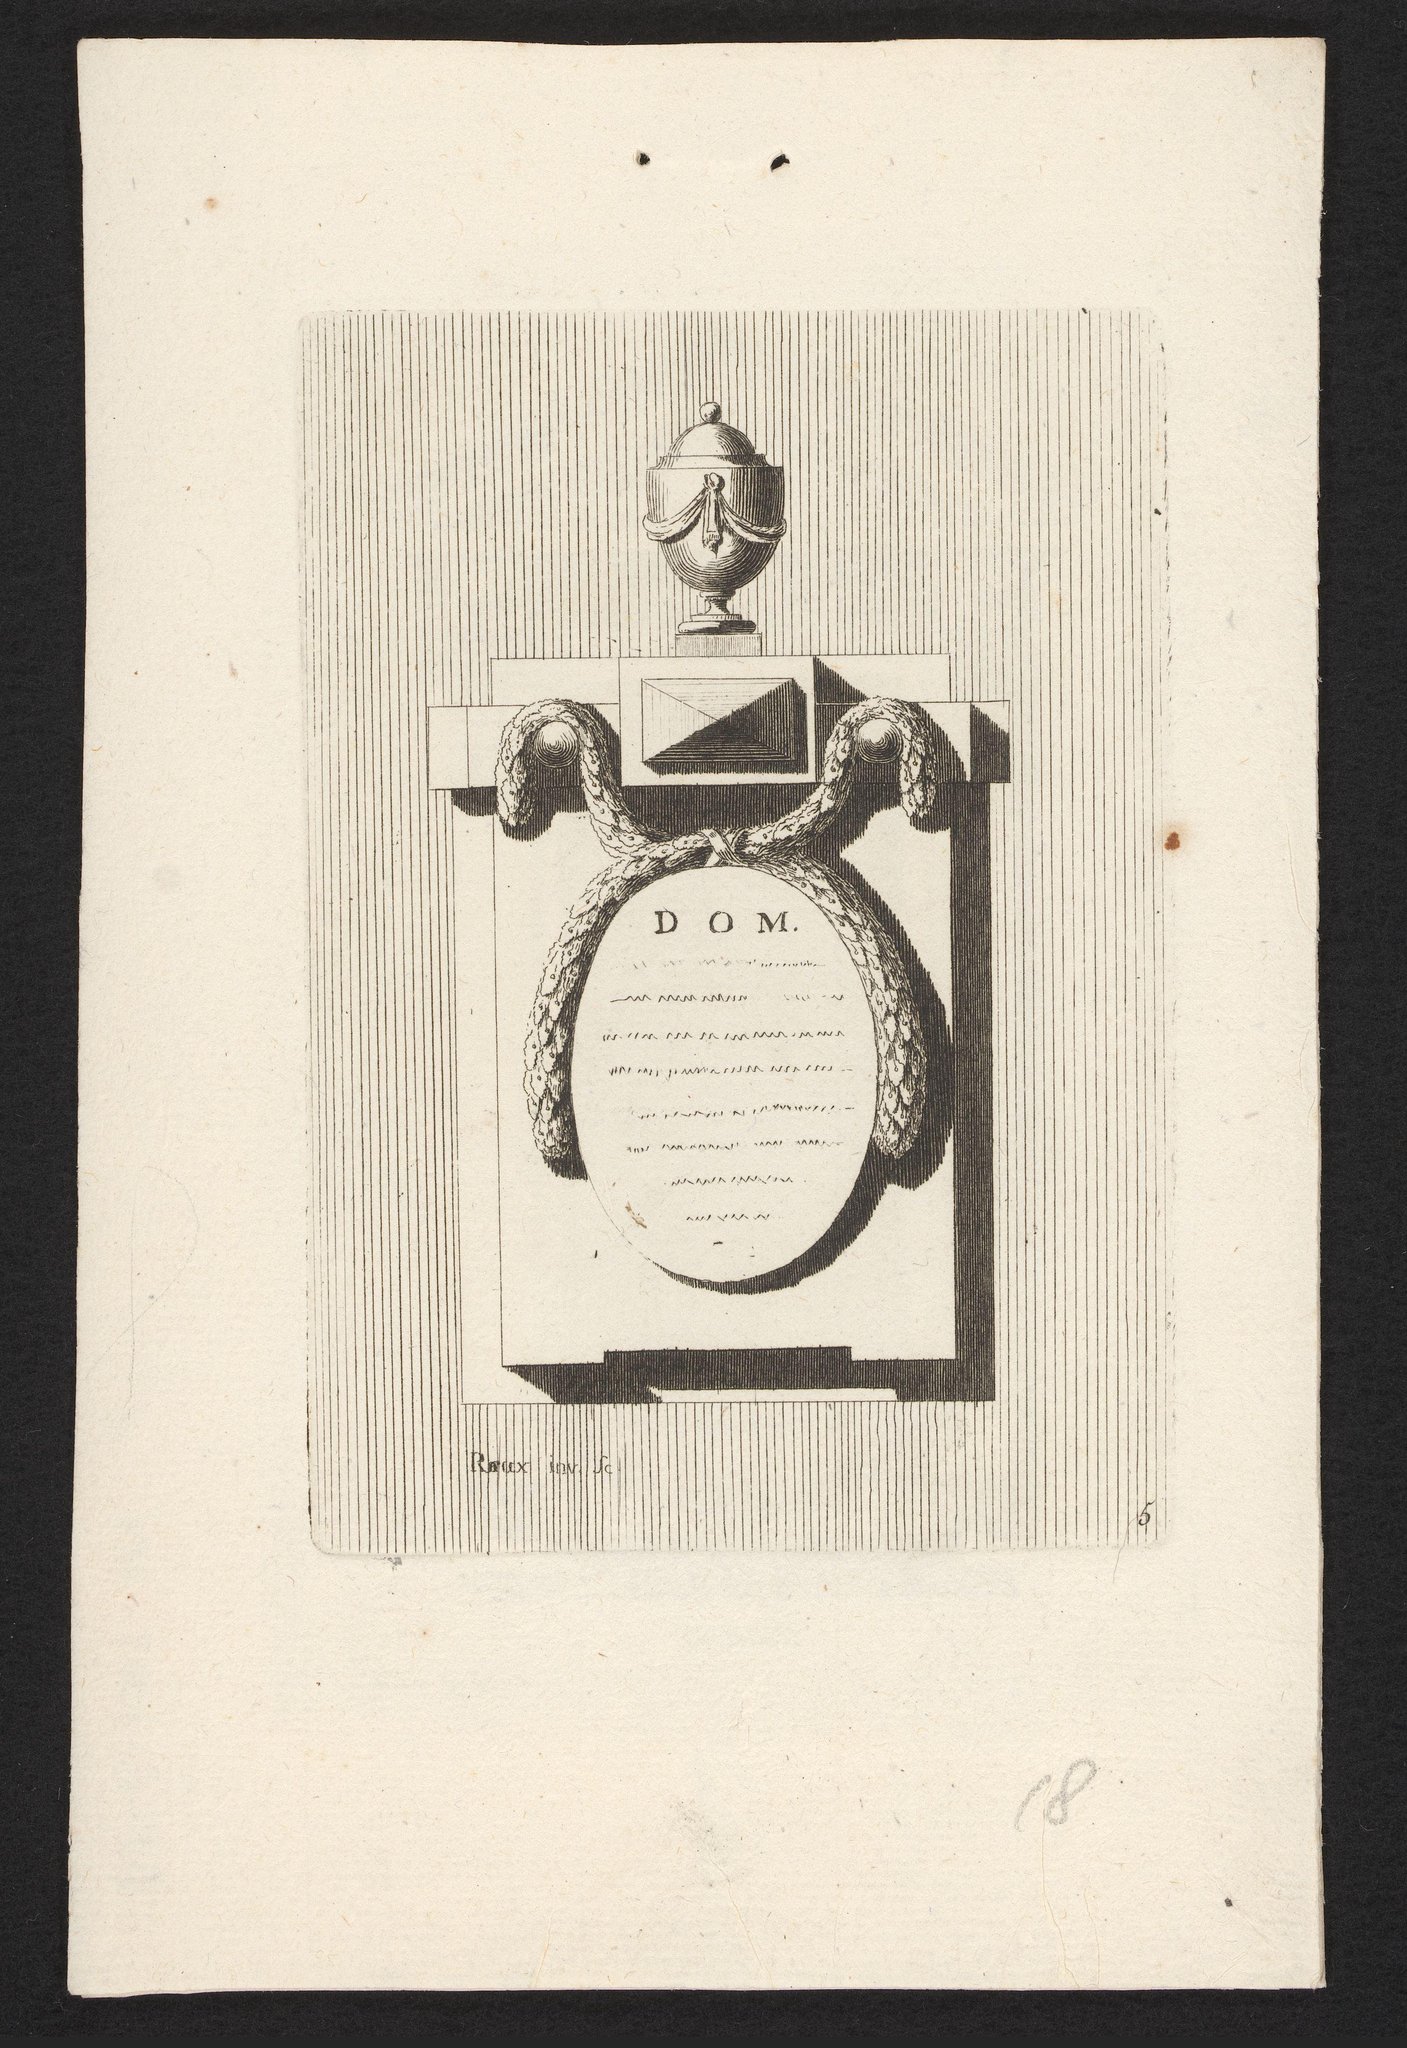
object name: ornament print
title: Epitaaf met vaas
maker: raux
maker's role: print maker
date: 1758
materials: paper, fiber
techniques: etching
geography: france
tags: vase ~ ornament, epitaph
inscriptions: collector's mark: Lugt 2228, collector's mark: Lugt 2760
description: Prenten RP-P-2003-378 t/m 383 zijn aan elkaar gebonden.